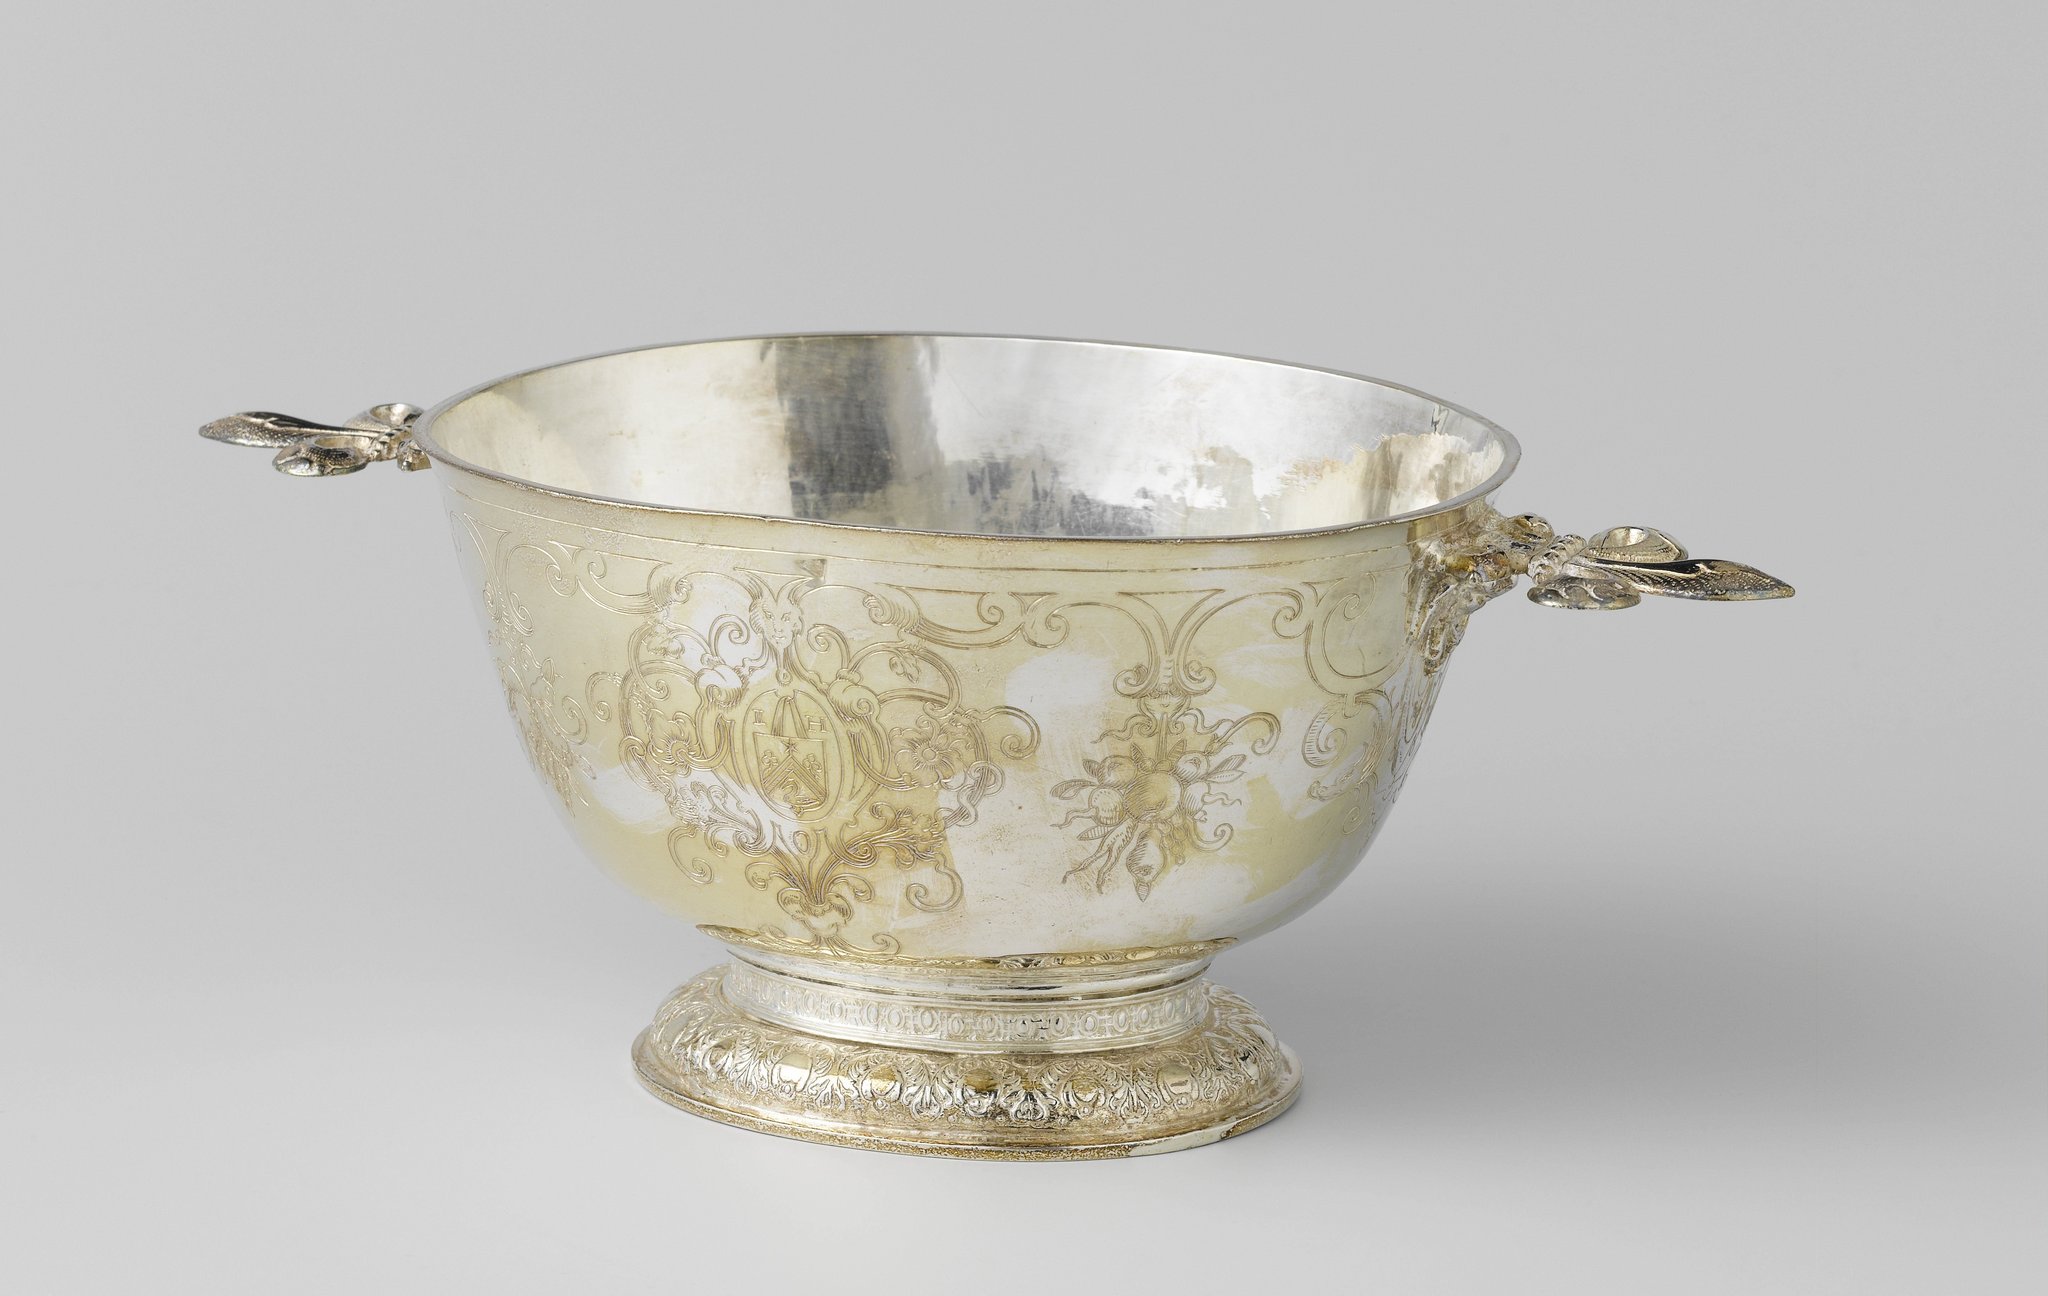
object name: brandy bowl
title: Brandewijnkom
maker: laurens thomas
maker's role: silversmith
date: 1642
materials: silver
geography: leeuwarden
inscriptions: mark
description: Brandy bowl. Silver. Leeuwarden, 1642, by Laurens Thomas.